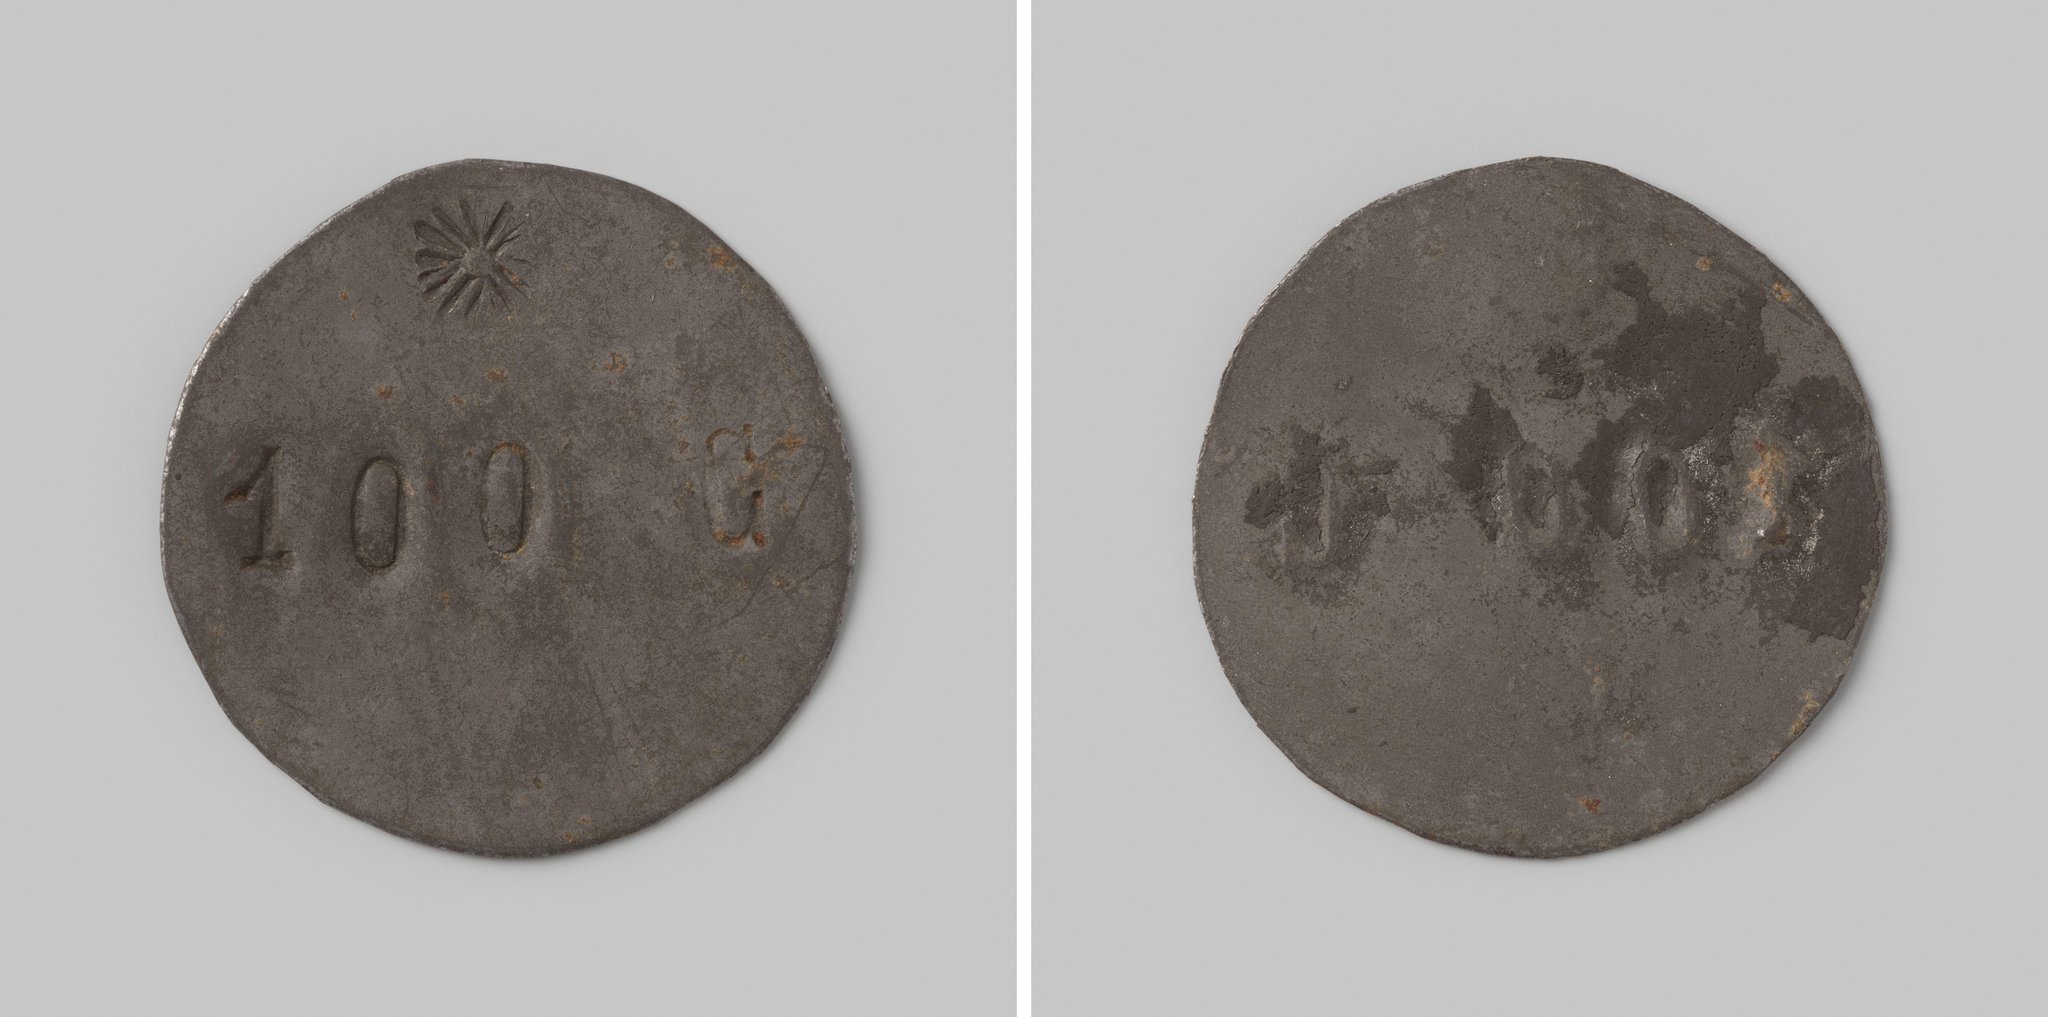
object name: history medal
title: Betaalpenning van 100 cents van de Coöperatieve Winkelvereeniging Eendracht Maakt Magt te Hilversum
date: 1875-1900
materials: brass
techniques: printing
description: Rond zinken plaatje met inwaartse instempelingen (ster) / 100 C